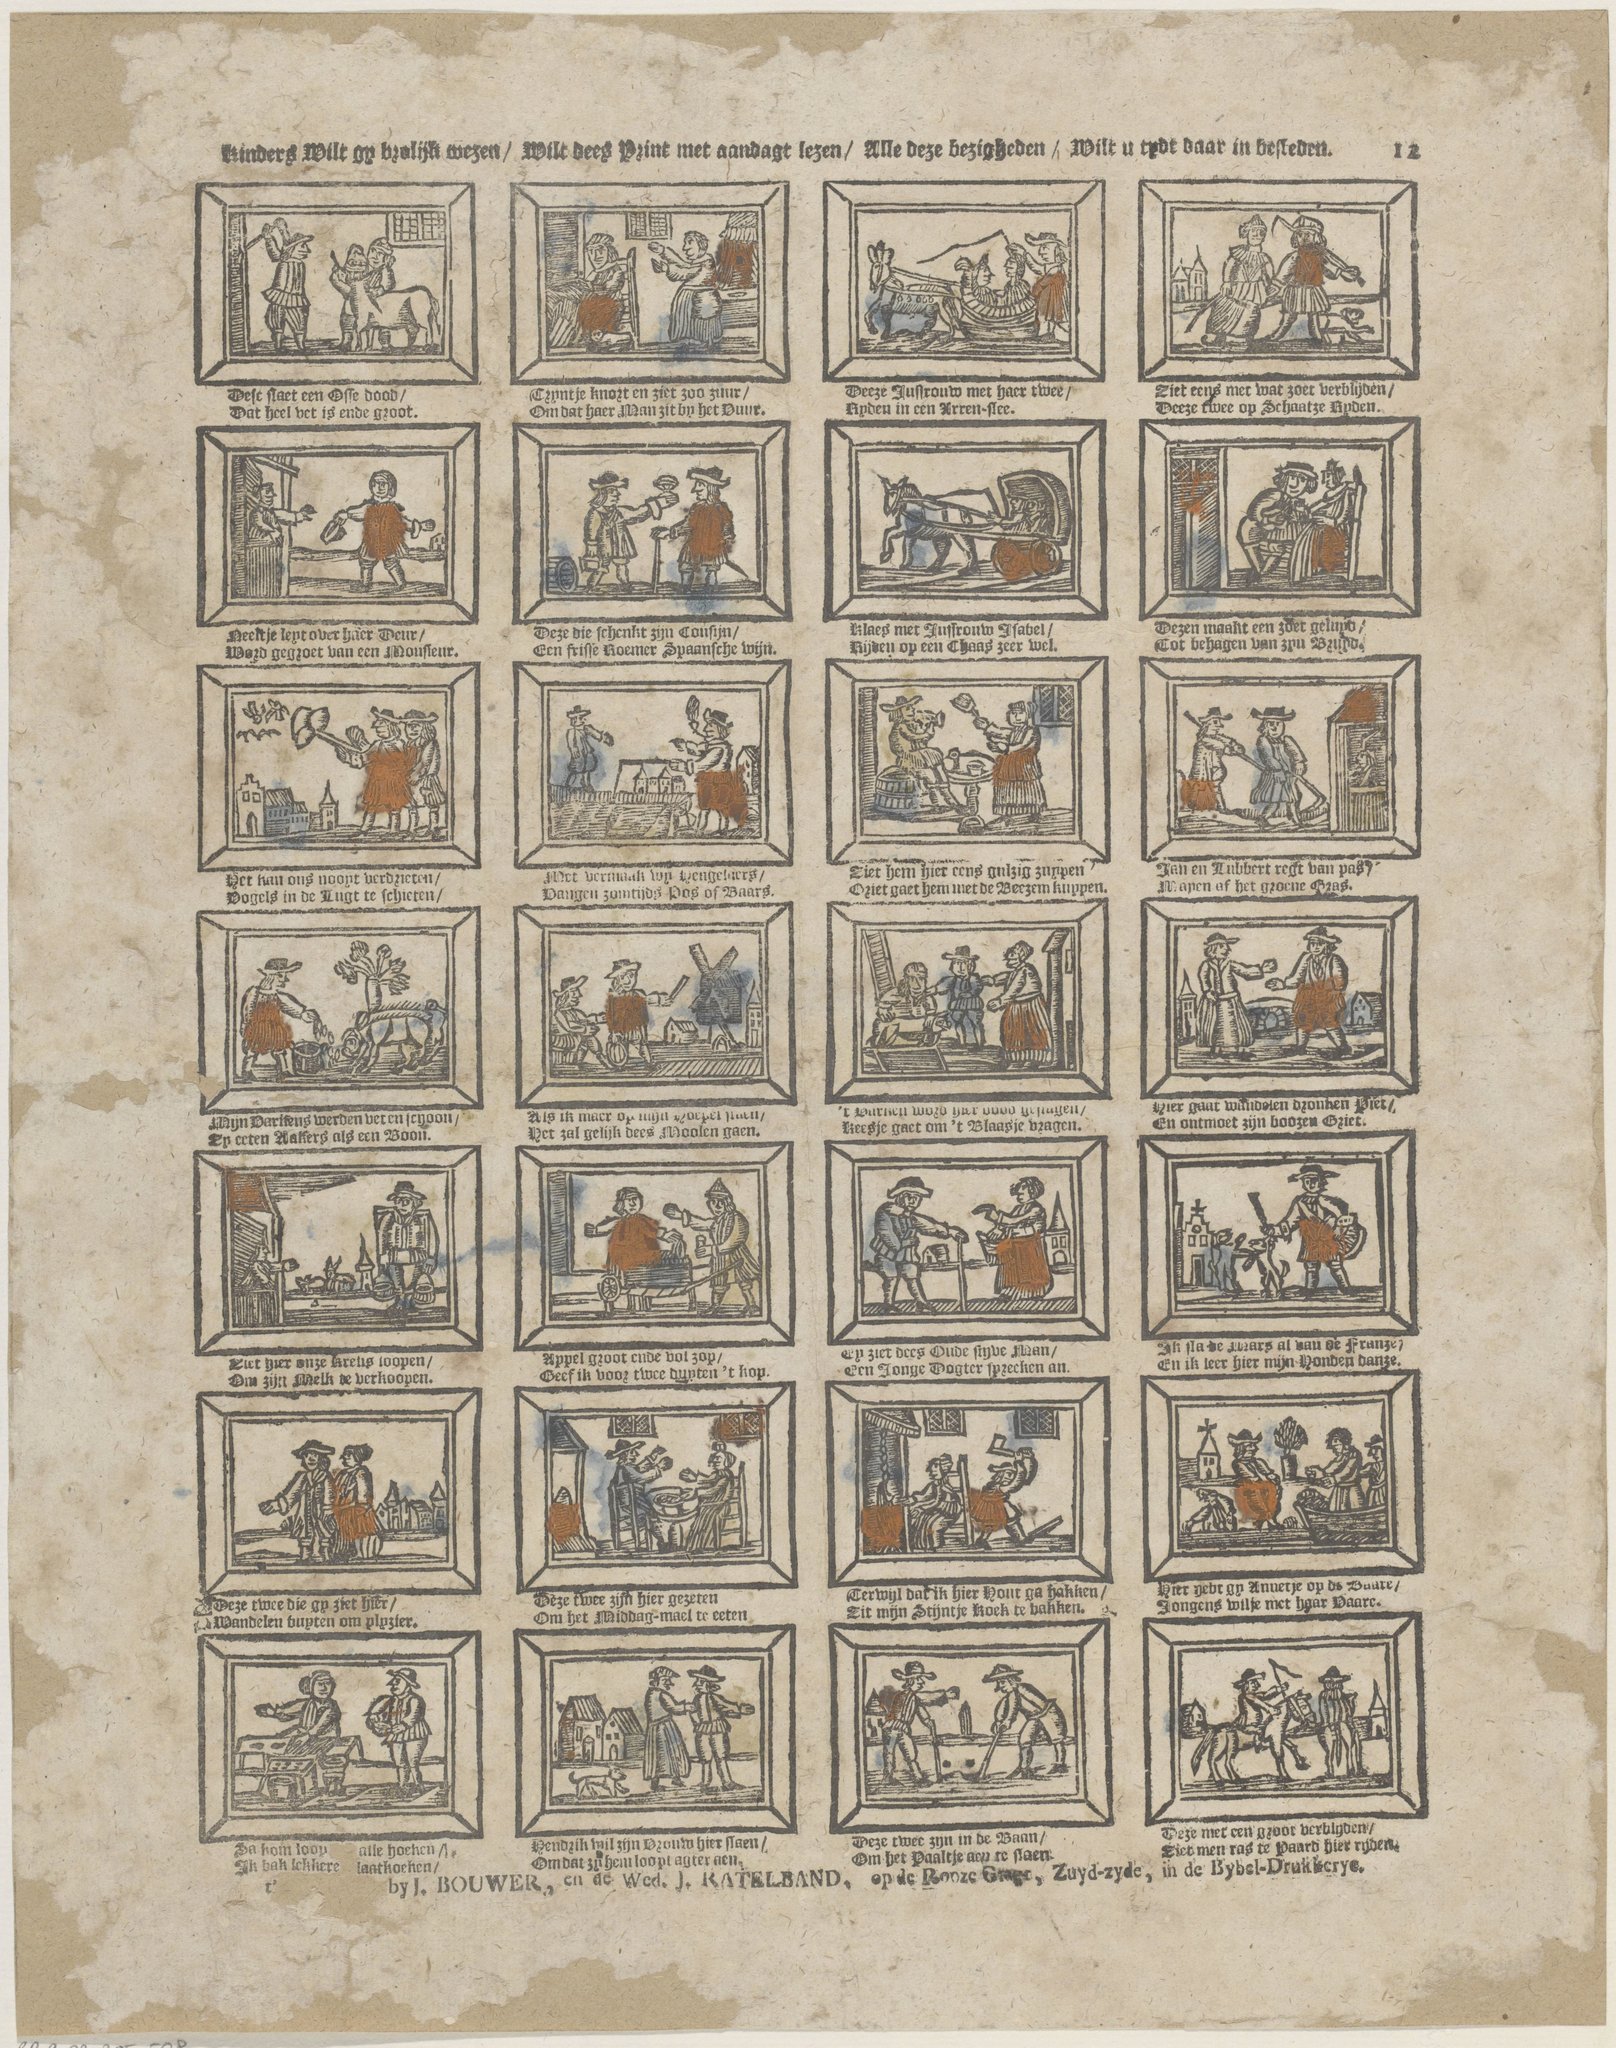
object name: popular print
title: Kinders wilt gy vrolijk wezen / Wilt dees print met aandagt lezen / Alle deze bezigheden / Wilt u tydt daar in besteden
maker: Anonymous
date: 1794-1804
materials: paper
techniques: colour, letterpress printing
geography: netherlands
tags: society, civilization, culture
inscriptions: collector's mark: Lugt 2760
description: Blad met 28 voorstellingen van verschillende bezigheden uit het dagelijks leven. Elk plaatje in een miniatuur schilderijlijst met een tweeregelig vers. Genummerd rechtsboven: 12.